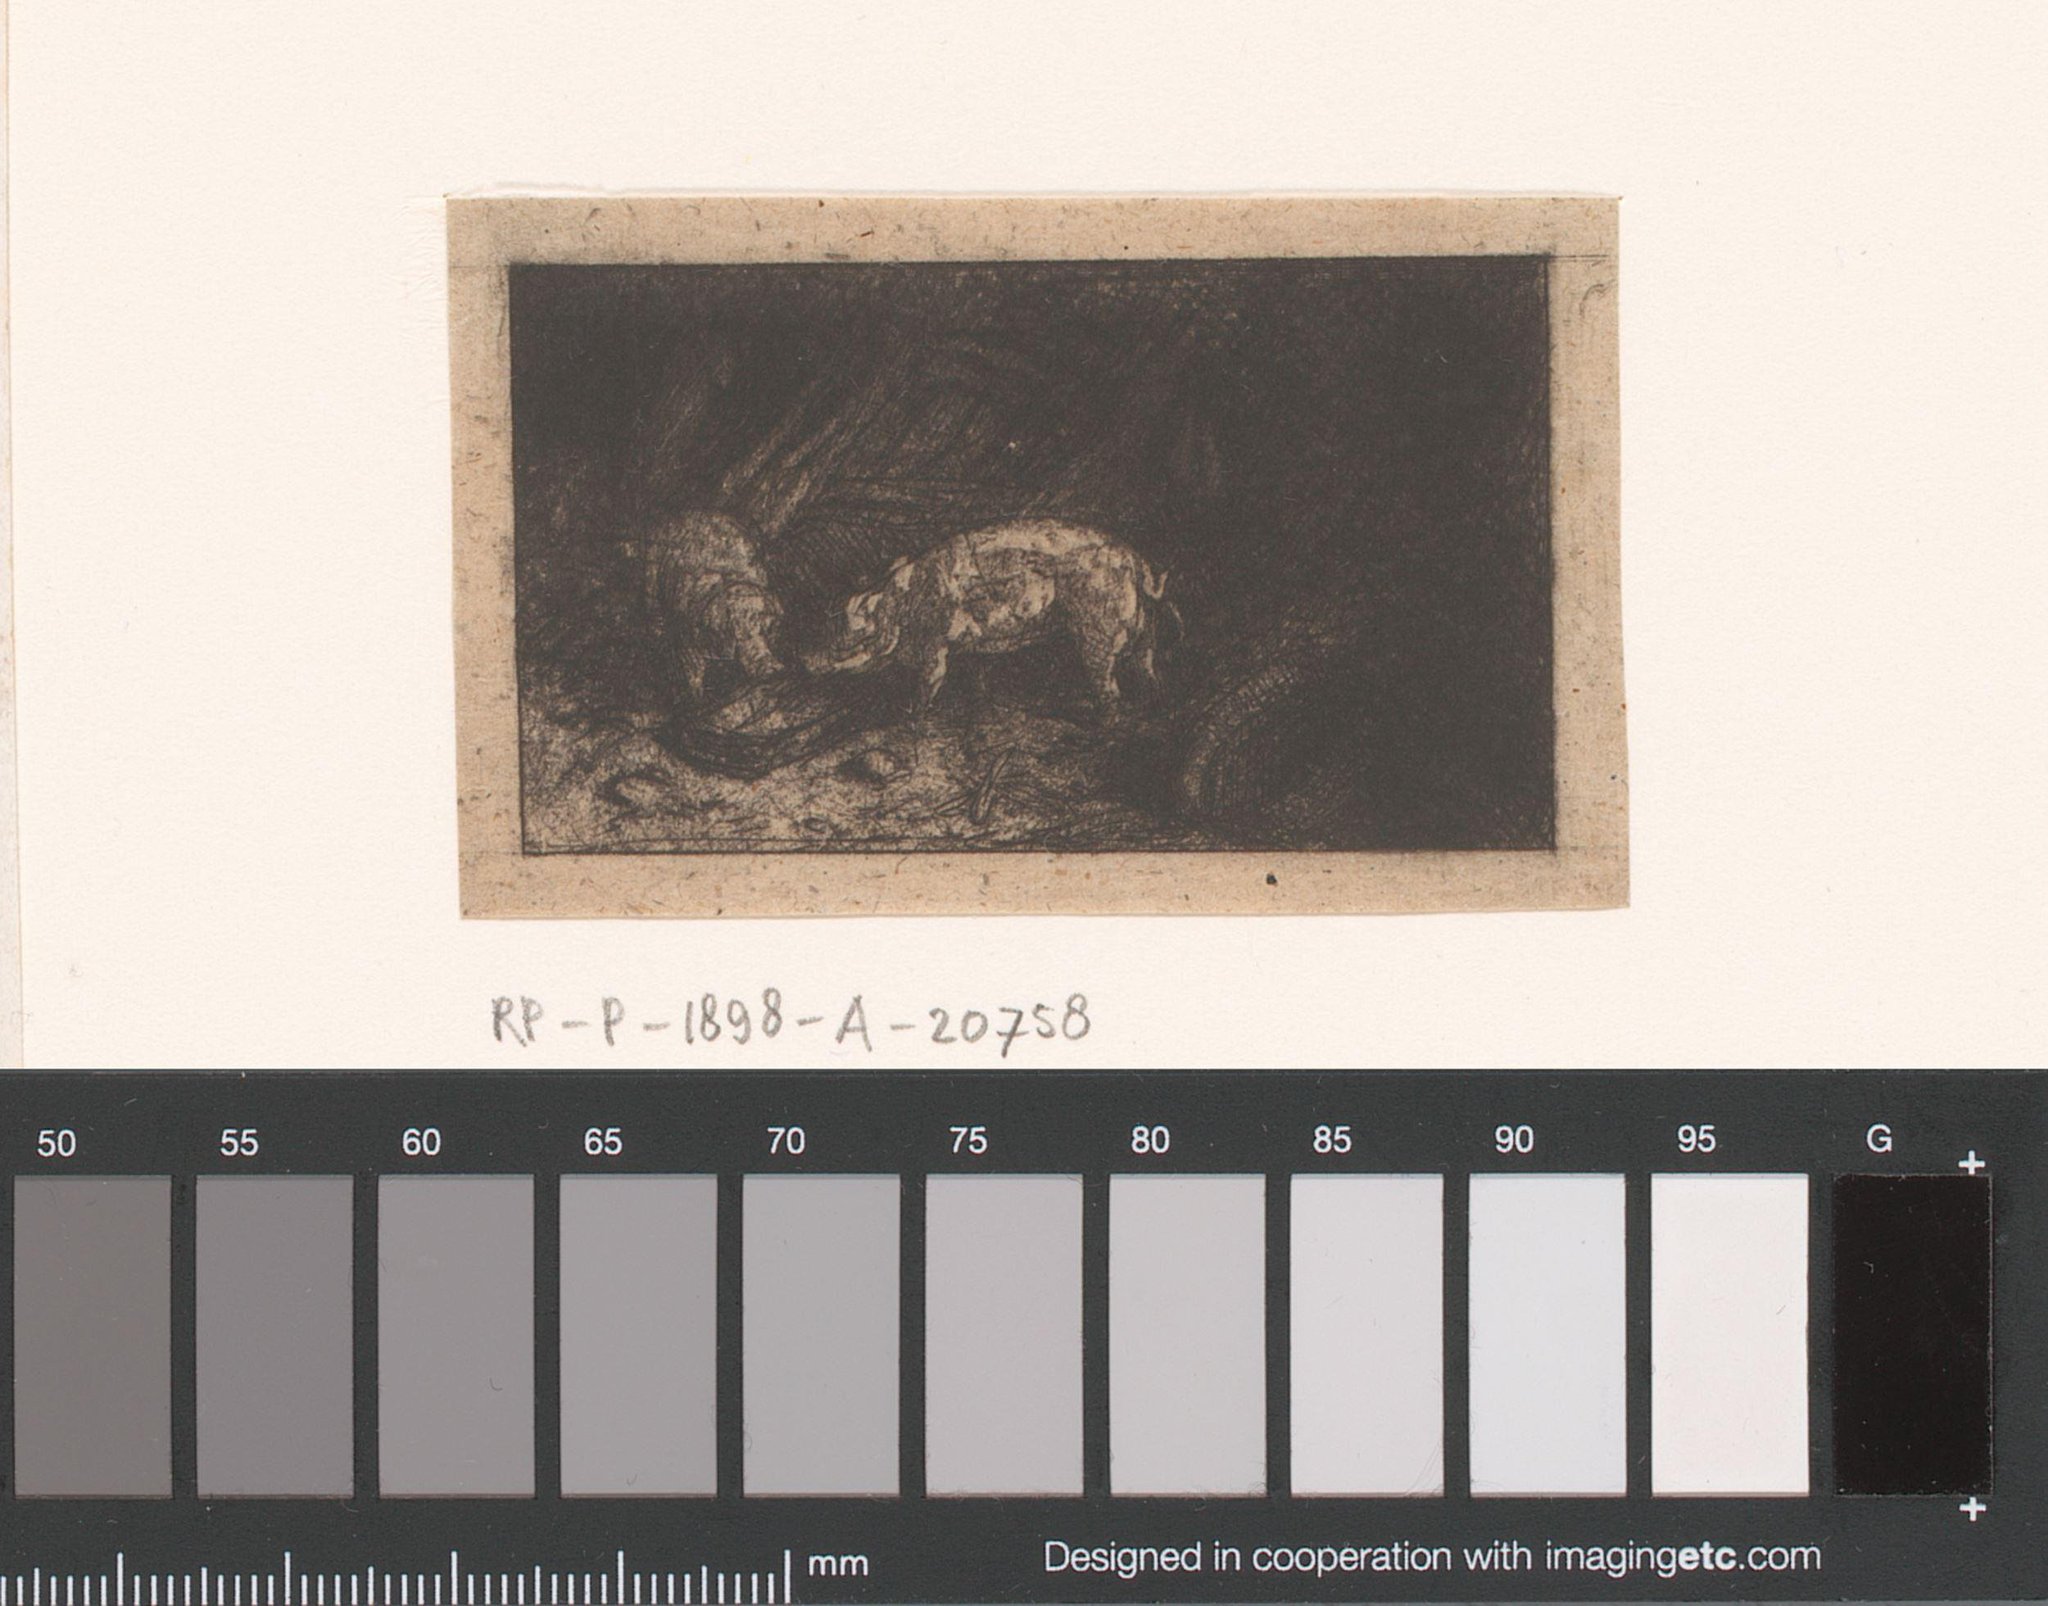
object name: print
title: Twee etende varkens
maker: charles emile jacque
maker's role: draughtsman, painter, print maker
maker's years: 1813-1894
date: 1844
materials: paper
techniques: etching, intaglio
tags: trough, pig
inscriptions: collector's mark: Lugt 964